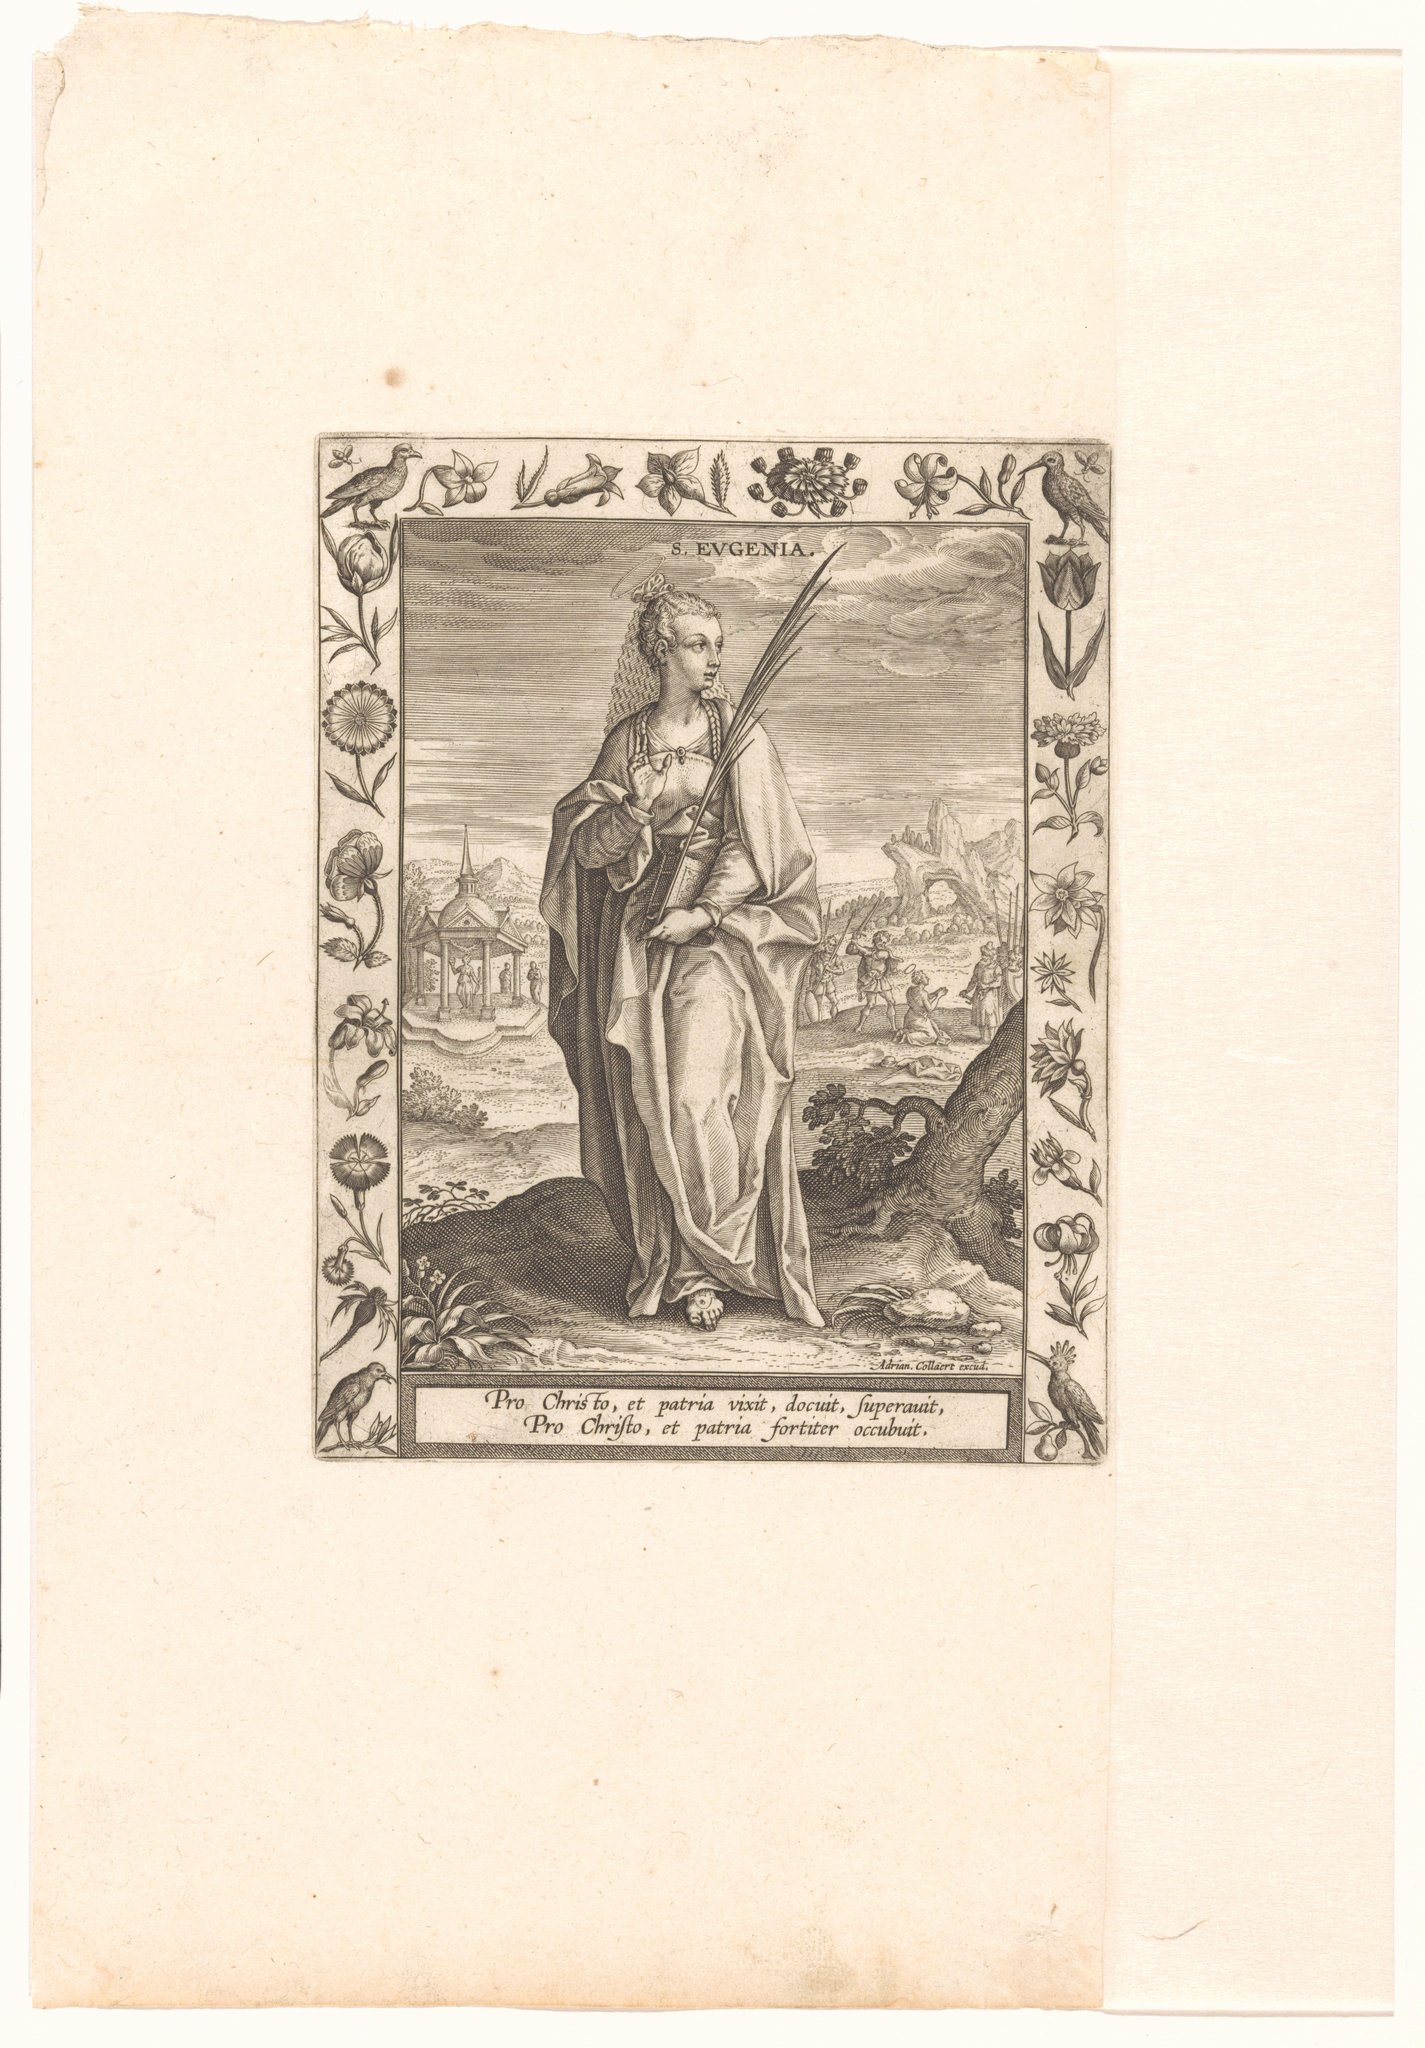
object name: print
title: Heilige Eugenia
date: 1590-1610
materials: paper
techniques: engraving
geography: antwerp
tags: flowers, female saints (with name), birds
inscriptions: collector's mark: Lugt 2228, collector's mark: Lugt 3751, collector's mark: Lugt 2760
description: Heilige Eugenia. Onderdeel van een serie van 24 voorstellingen van vrouwelijke martelaren (martyrologium). De voorstellingen zijn voorzien van randen met bloemen en dieren.